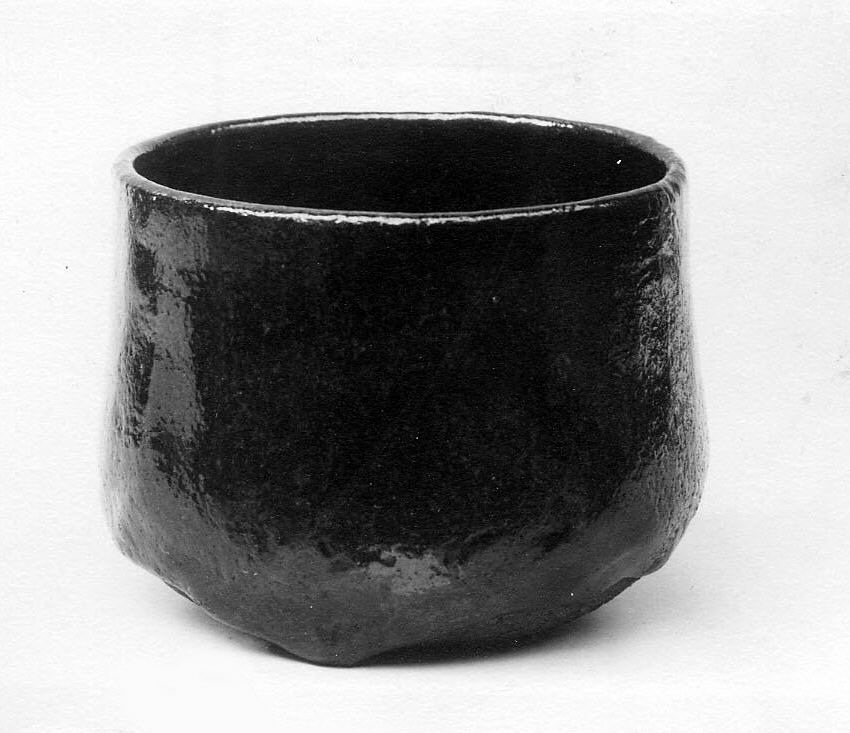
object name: teabowl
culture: japanese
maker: honnami kuchu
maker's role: artist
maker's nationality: japanese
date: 1630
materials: clay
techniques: overglaze, underglaze